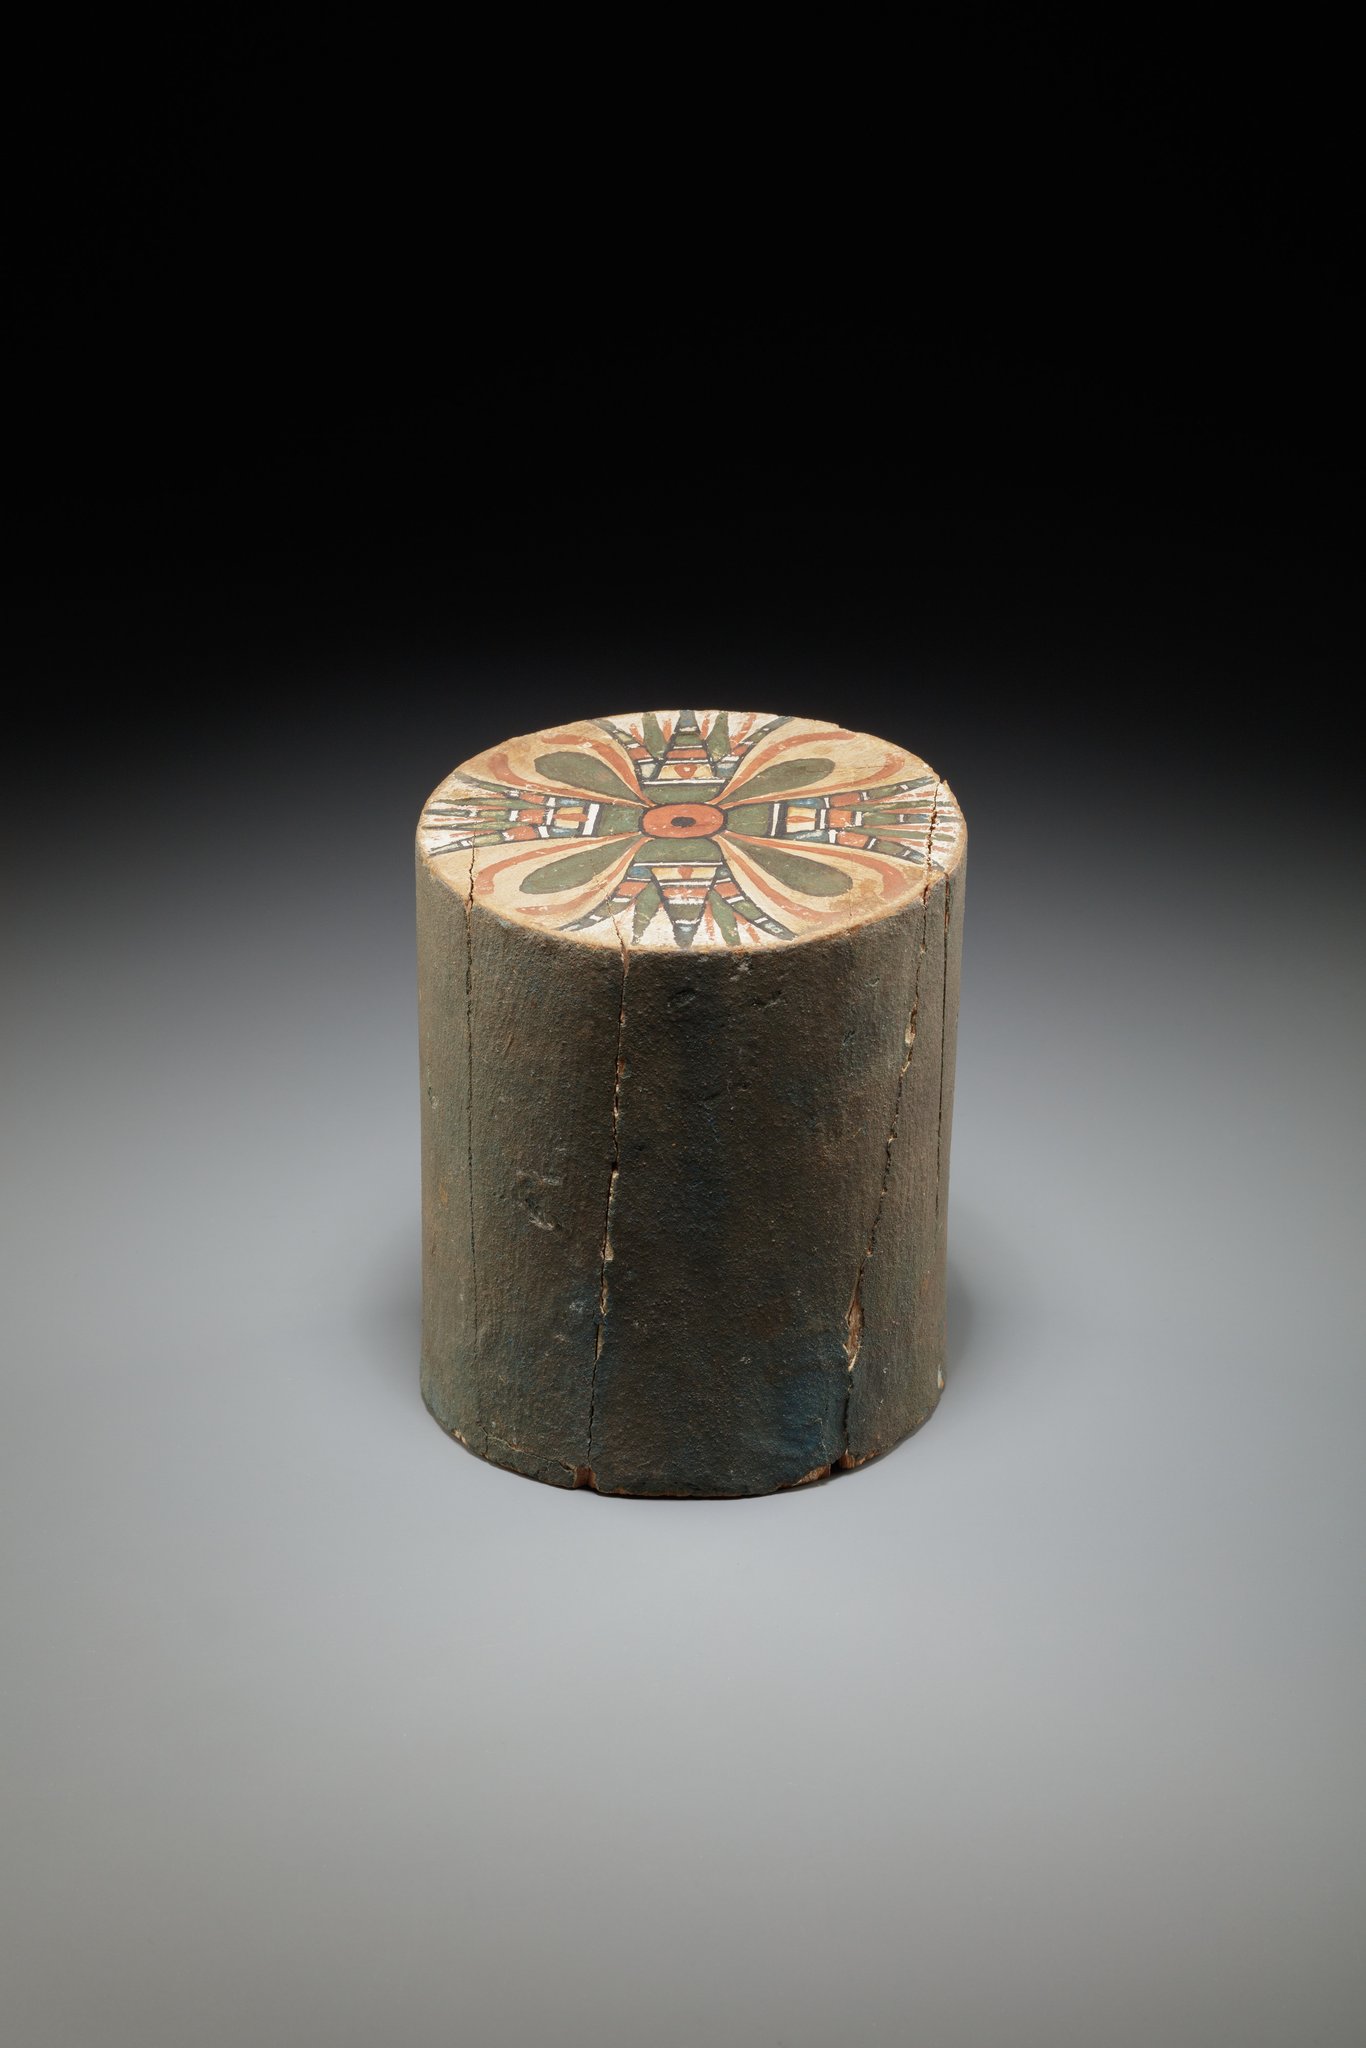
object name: coffin knob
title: Coffin knob (?)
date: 1981-1550 BCE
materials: paint, wood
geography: egypt